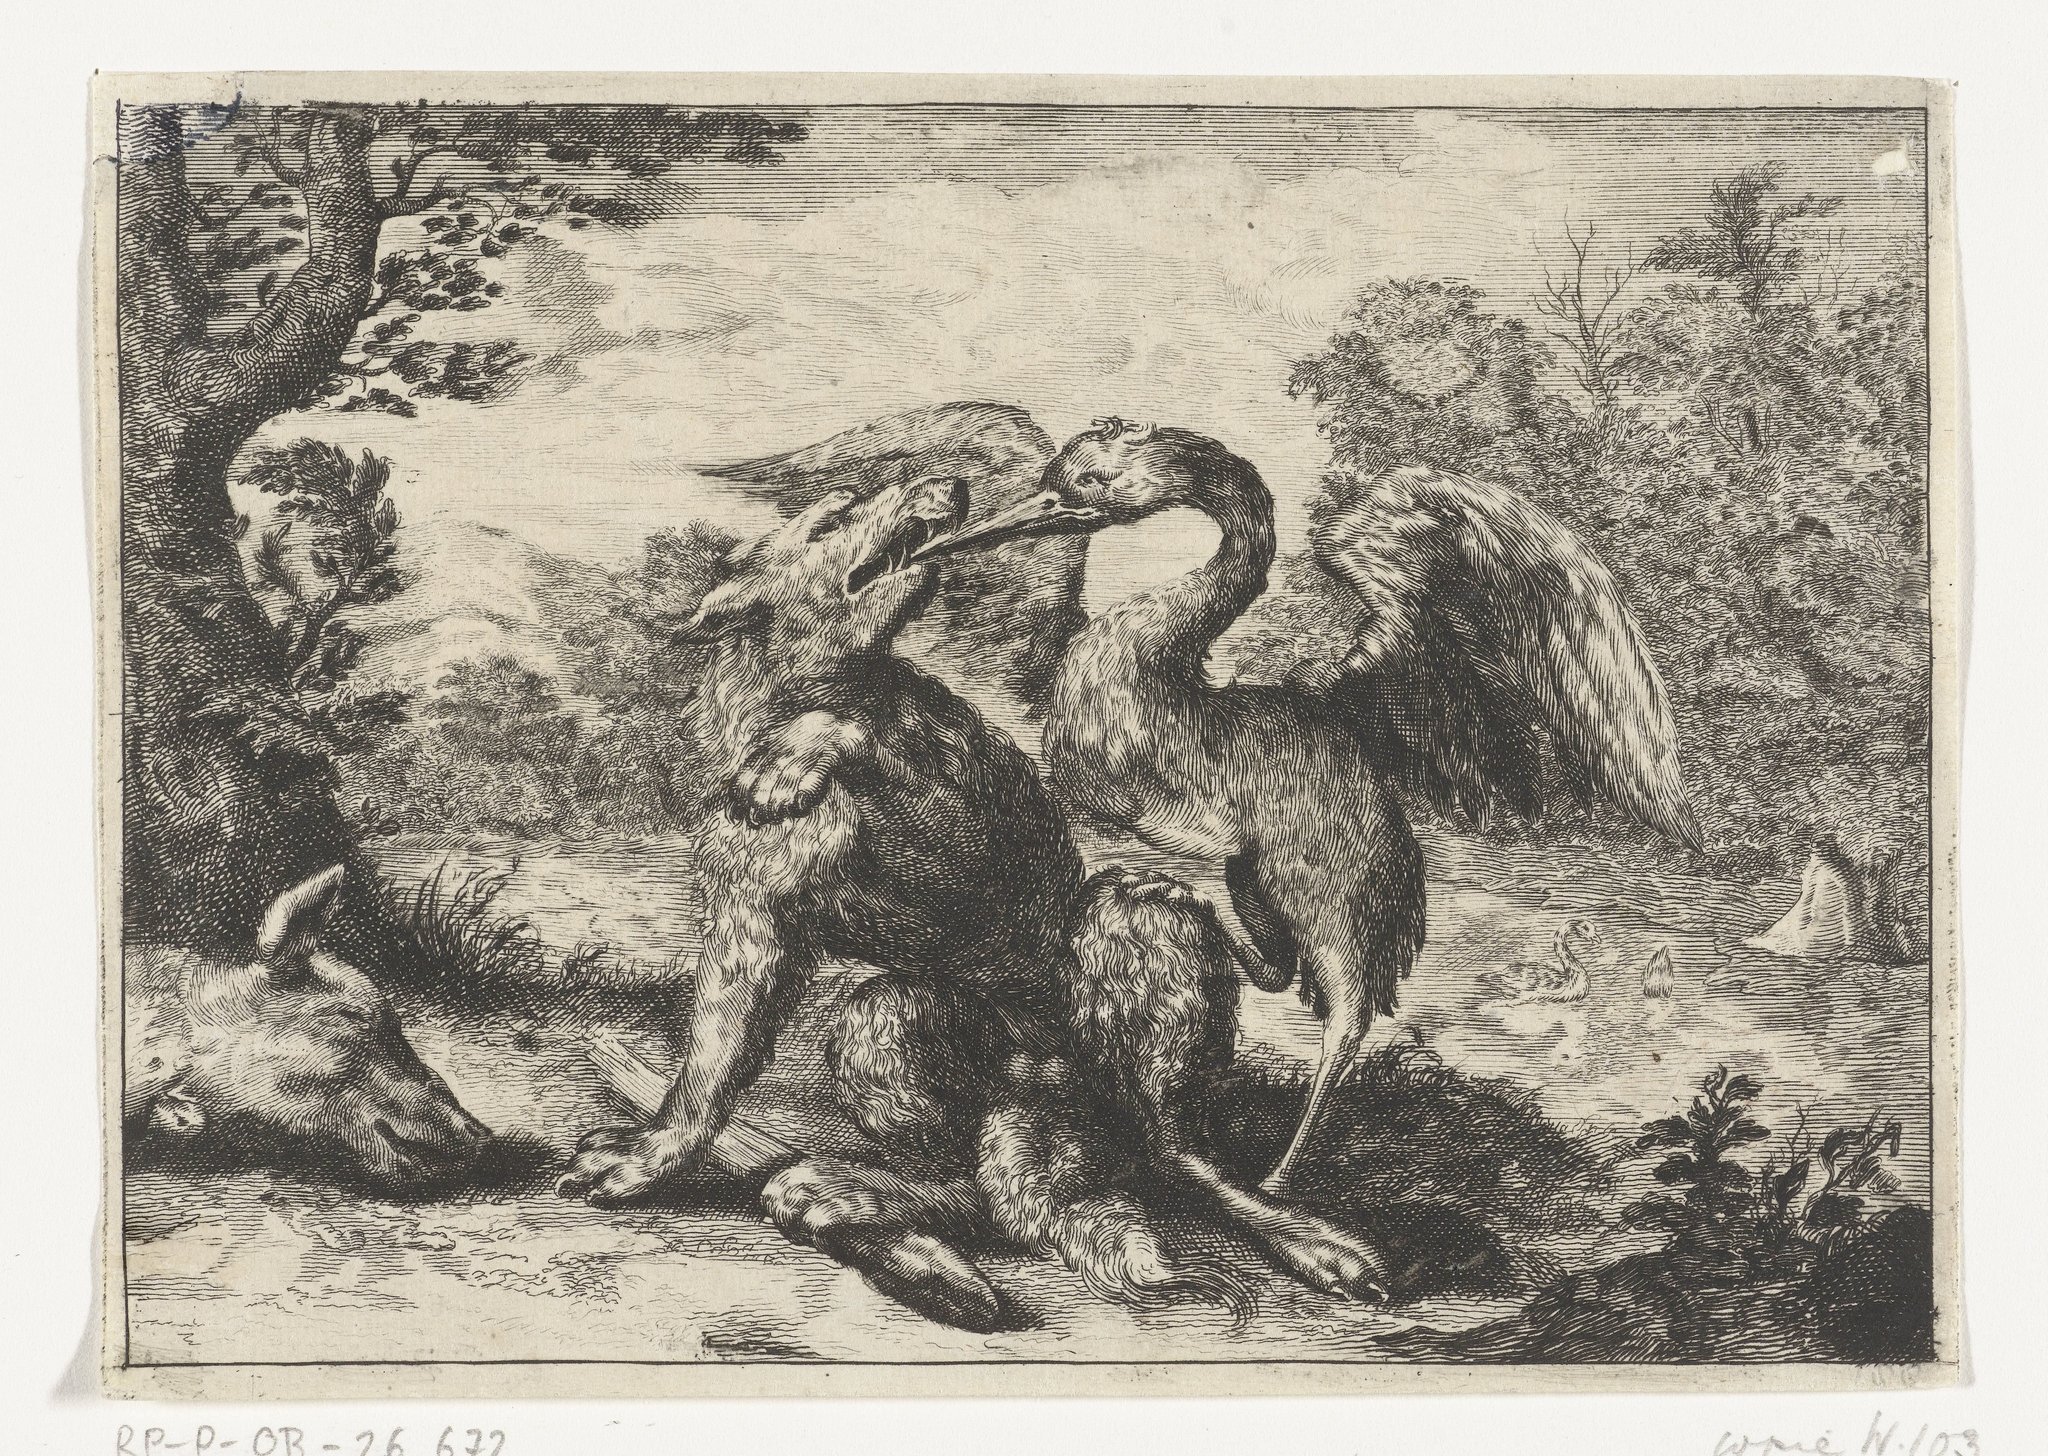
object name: print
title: Wolf en kraanvogel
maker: Anonymous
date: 1655-1740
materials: paper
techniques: etching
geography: netherlands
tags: shore-birds and wading-birds: crane, fables of aesop : use 85(...), beasts of prey, predatory animals: wolf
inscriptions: collector's mark: Lugt 240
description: Een kraanvogel haalt met zijn snavel een botje uit de hals van een wolf. De wolf had een schaap buit gemaakt en bij het opeten ervan was een botje in zijn hals blijven steken. Deze voorstelling illustreert een verhaal uit de fabelen van Aesopus.